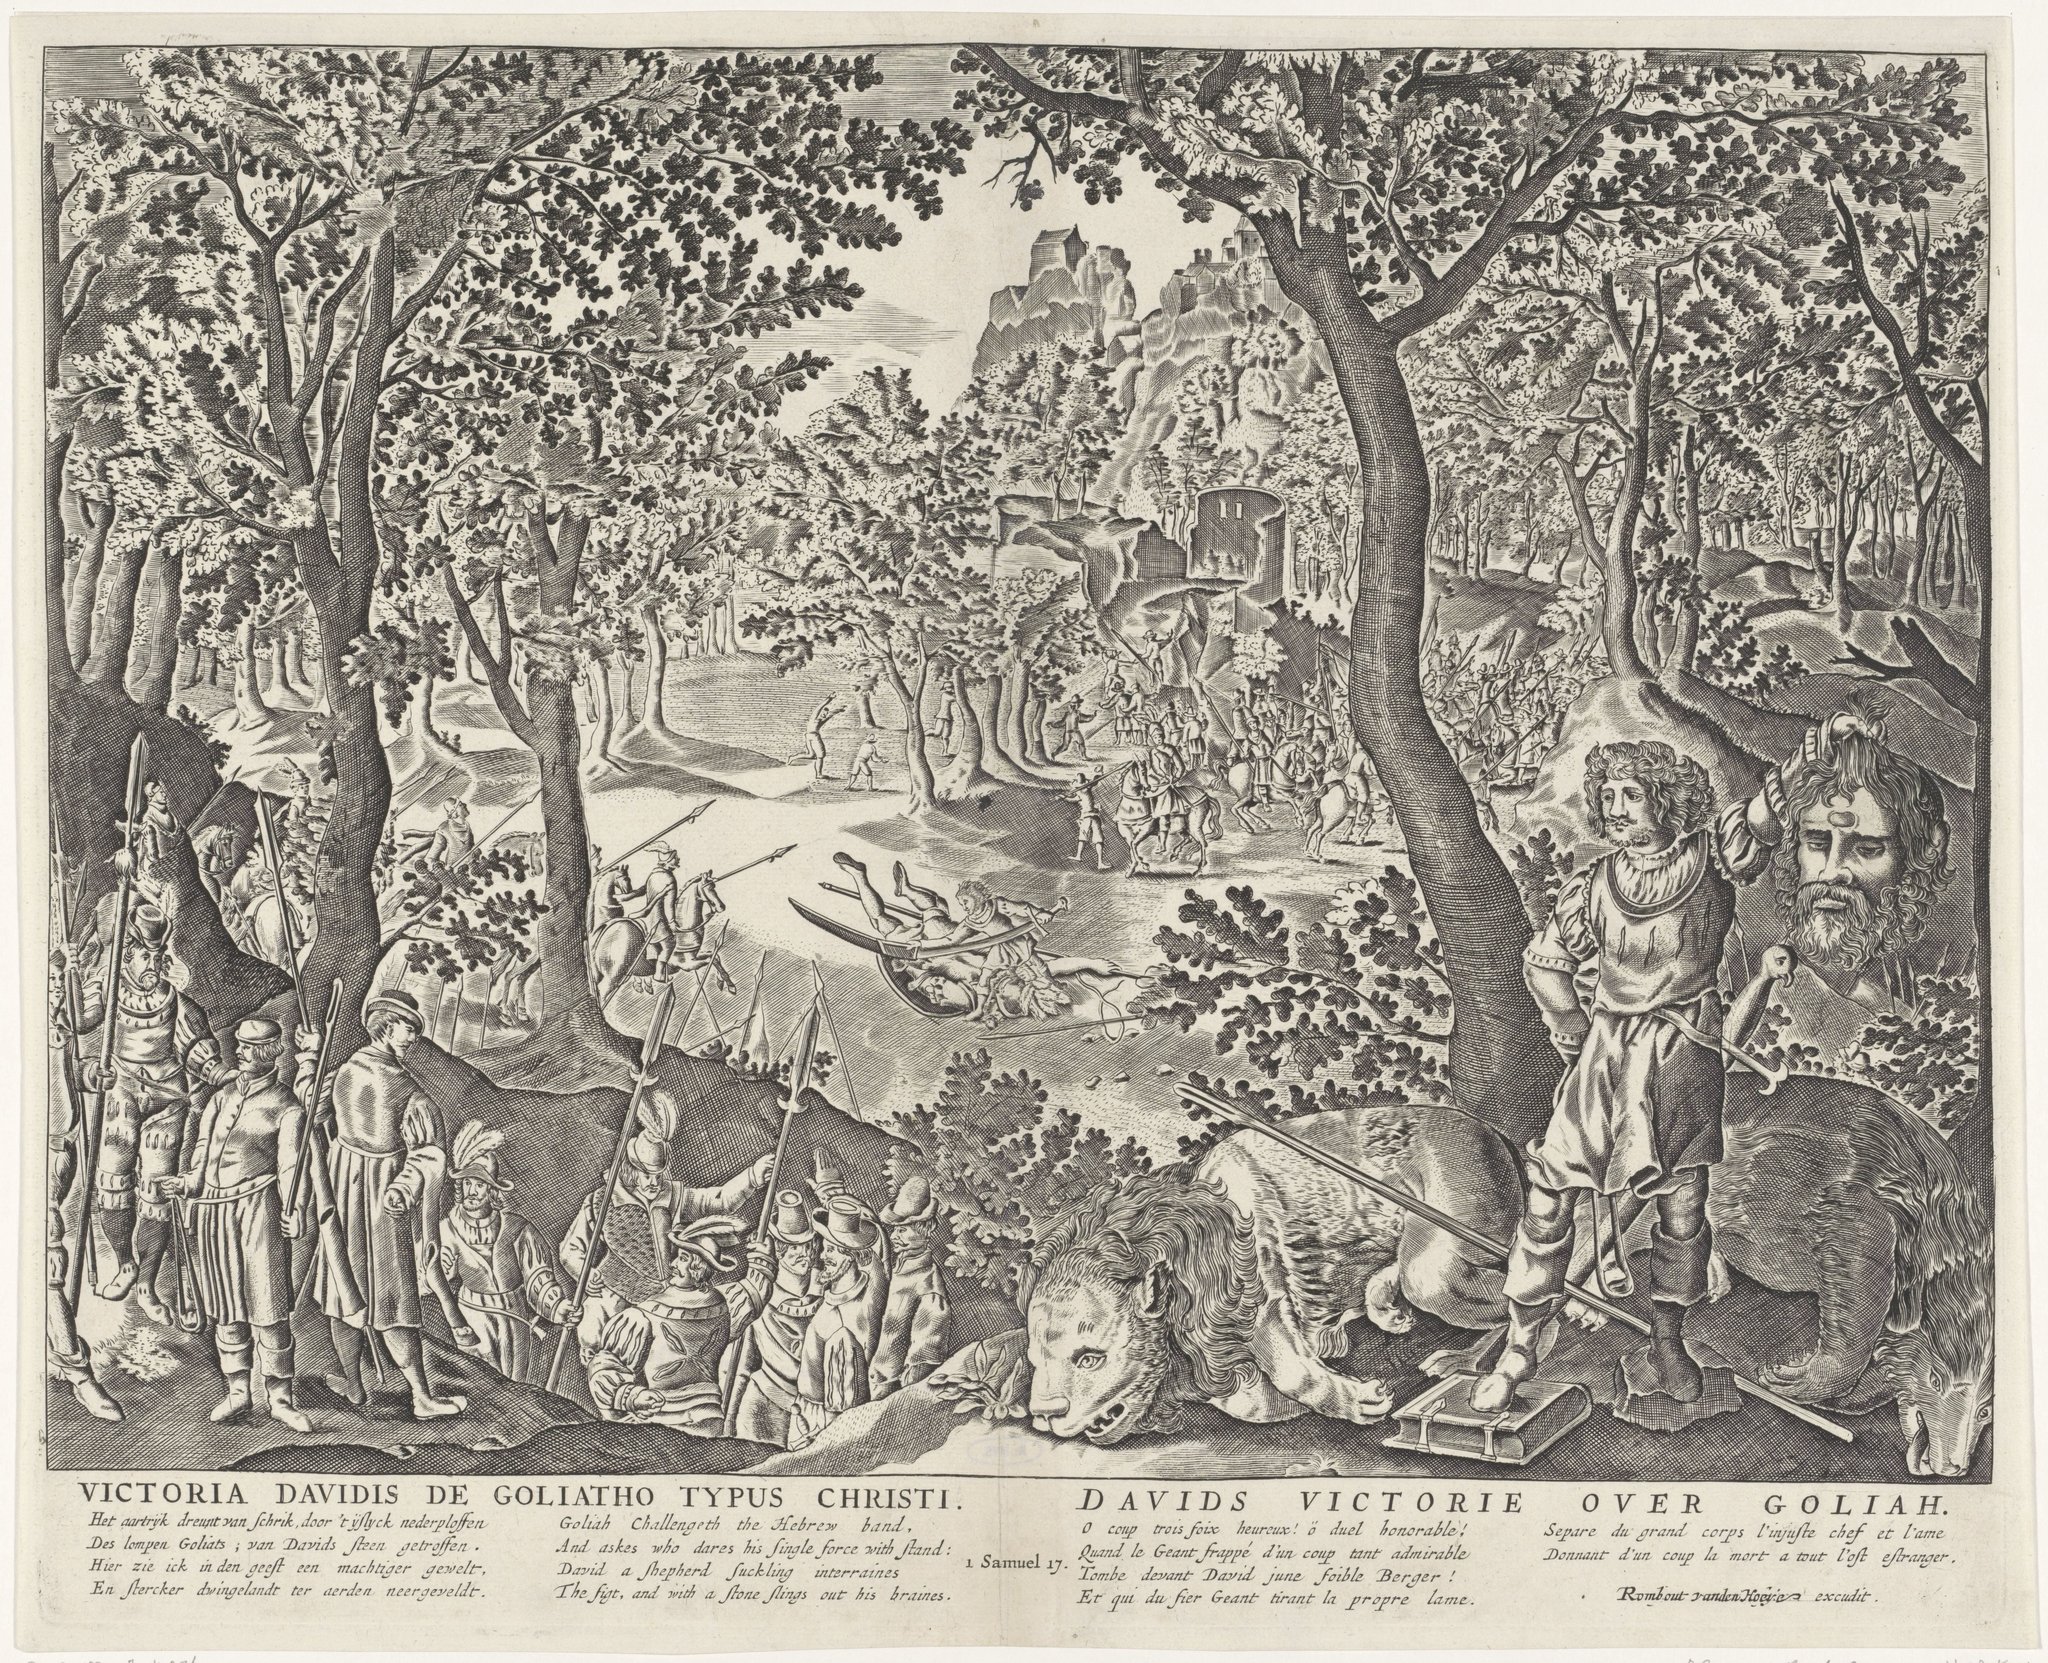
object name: print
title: Royaalbijbel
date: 1637-1671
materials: paper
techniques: engraving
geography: amsterdam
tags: david with goliath's head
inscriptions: collector's mark: Lugt 2228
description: David toont, rechts, het hoofd van Goliat, staande met en voet op een boek en naast hem een dode leeuw en beer. Op de achtergrond is zijn overwinning op Goliat te zien. David pakt het zwaard van Goliat om hem te onthoofden. Op de achtergrond vluchten de Filistijnen, terwijl de soldaten van Saul rechts de achtervolging inzetten. Onder de voorstelling een titel in het Latijn, drie vierregelige verzen in het Nederlands, Engels, Frans en twee tweeregelige verzen in het Frans. In het midden een verwijzing naar de Bijbeltekst in 1 Sam. 17.